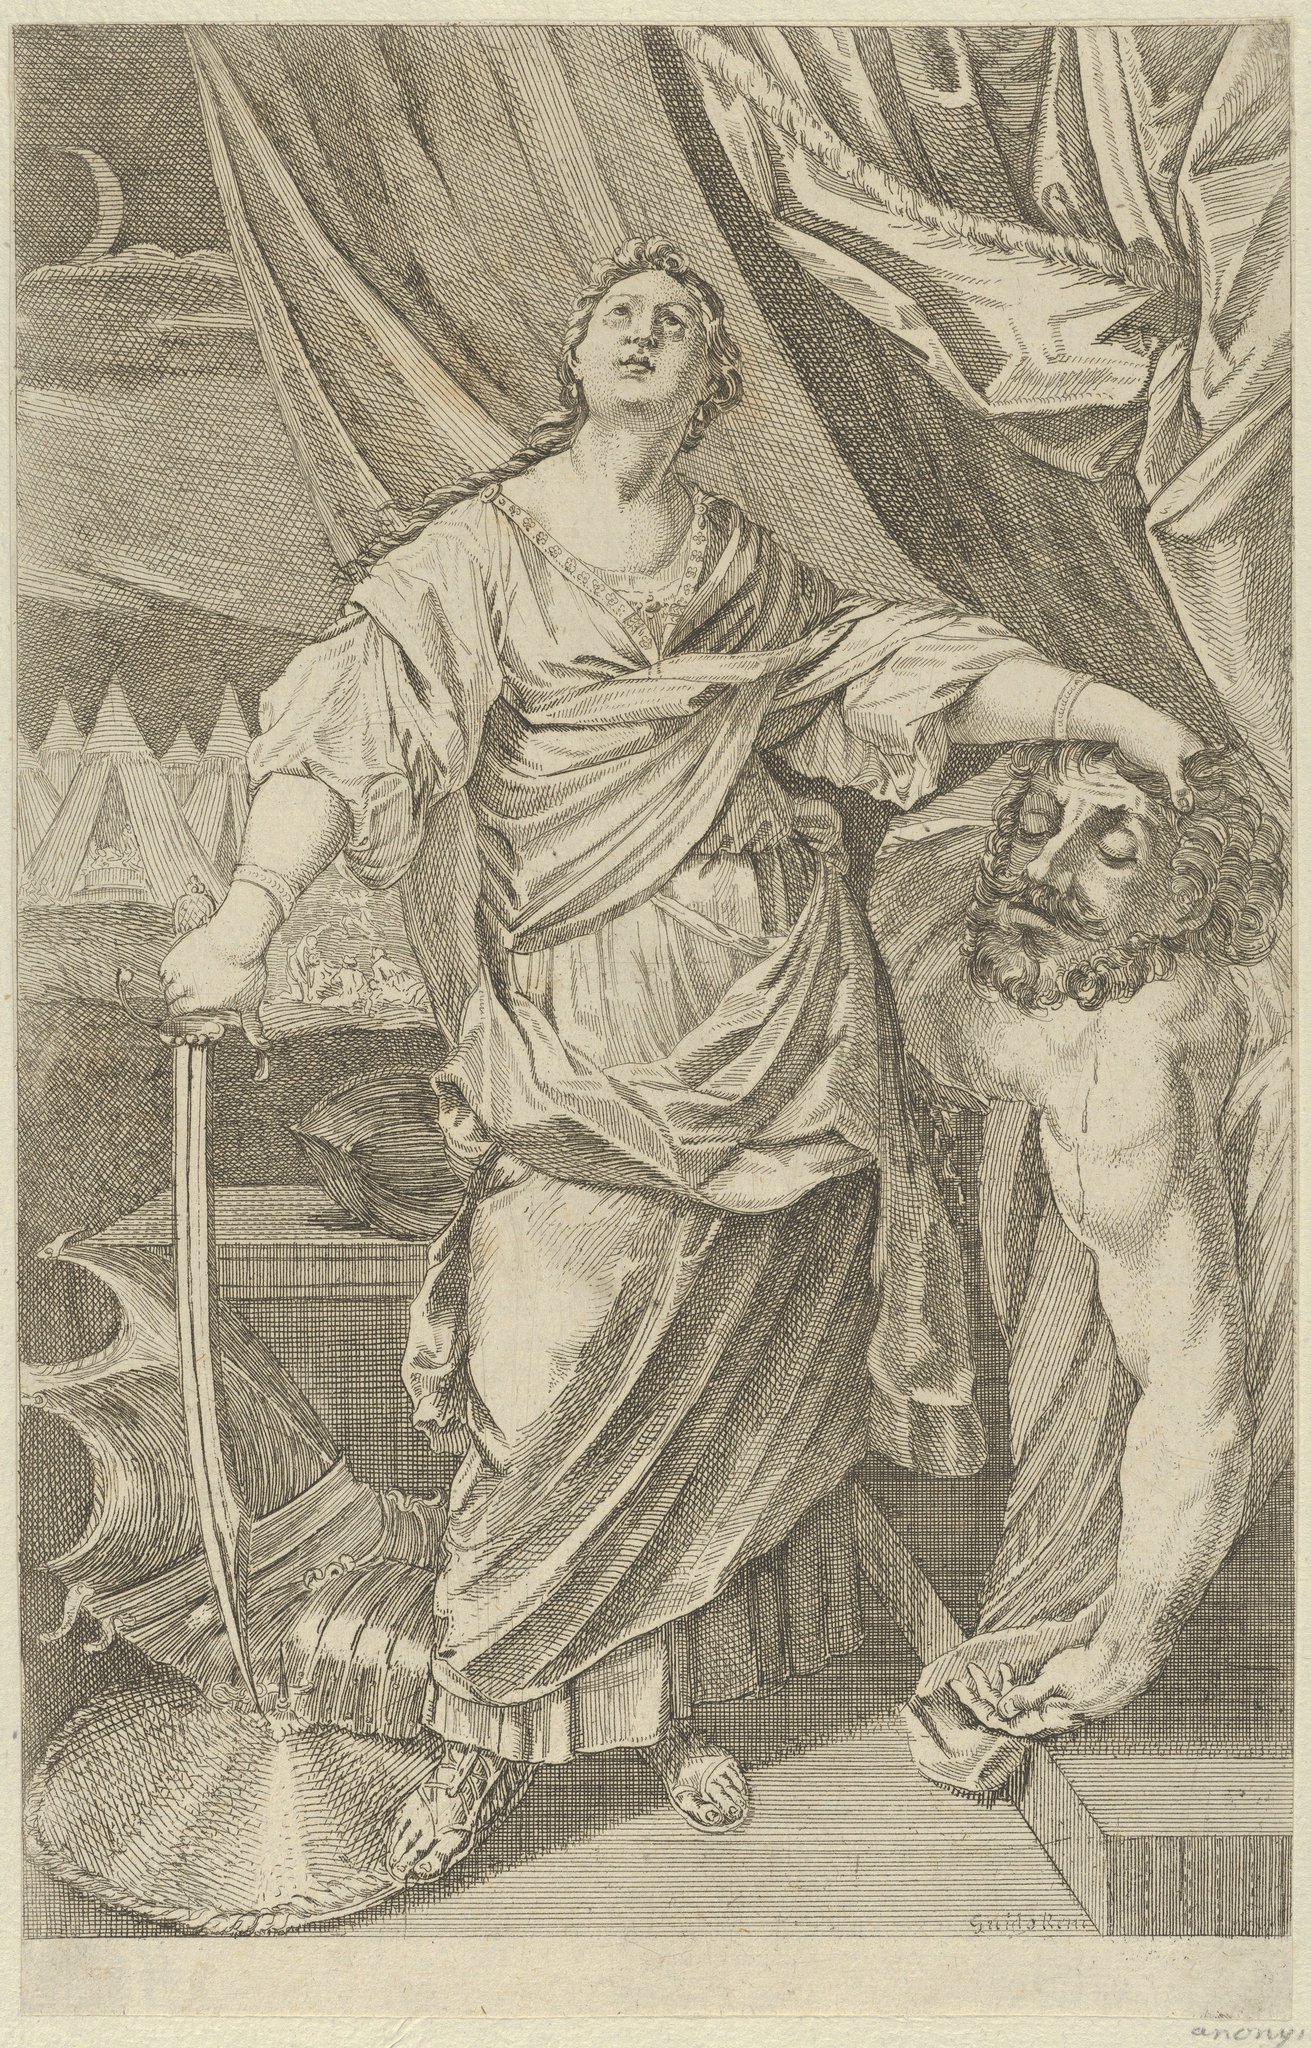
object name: print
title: Judith standing and looking up, holding the head of Holofernes in her left hand and a sword in her right, tents in the background, after Reni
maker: Anonymous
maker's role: artist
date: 1650-1750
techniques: etching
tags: swords,heads,judith